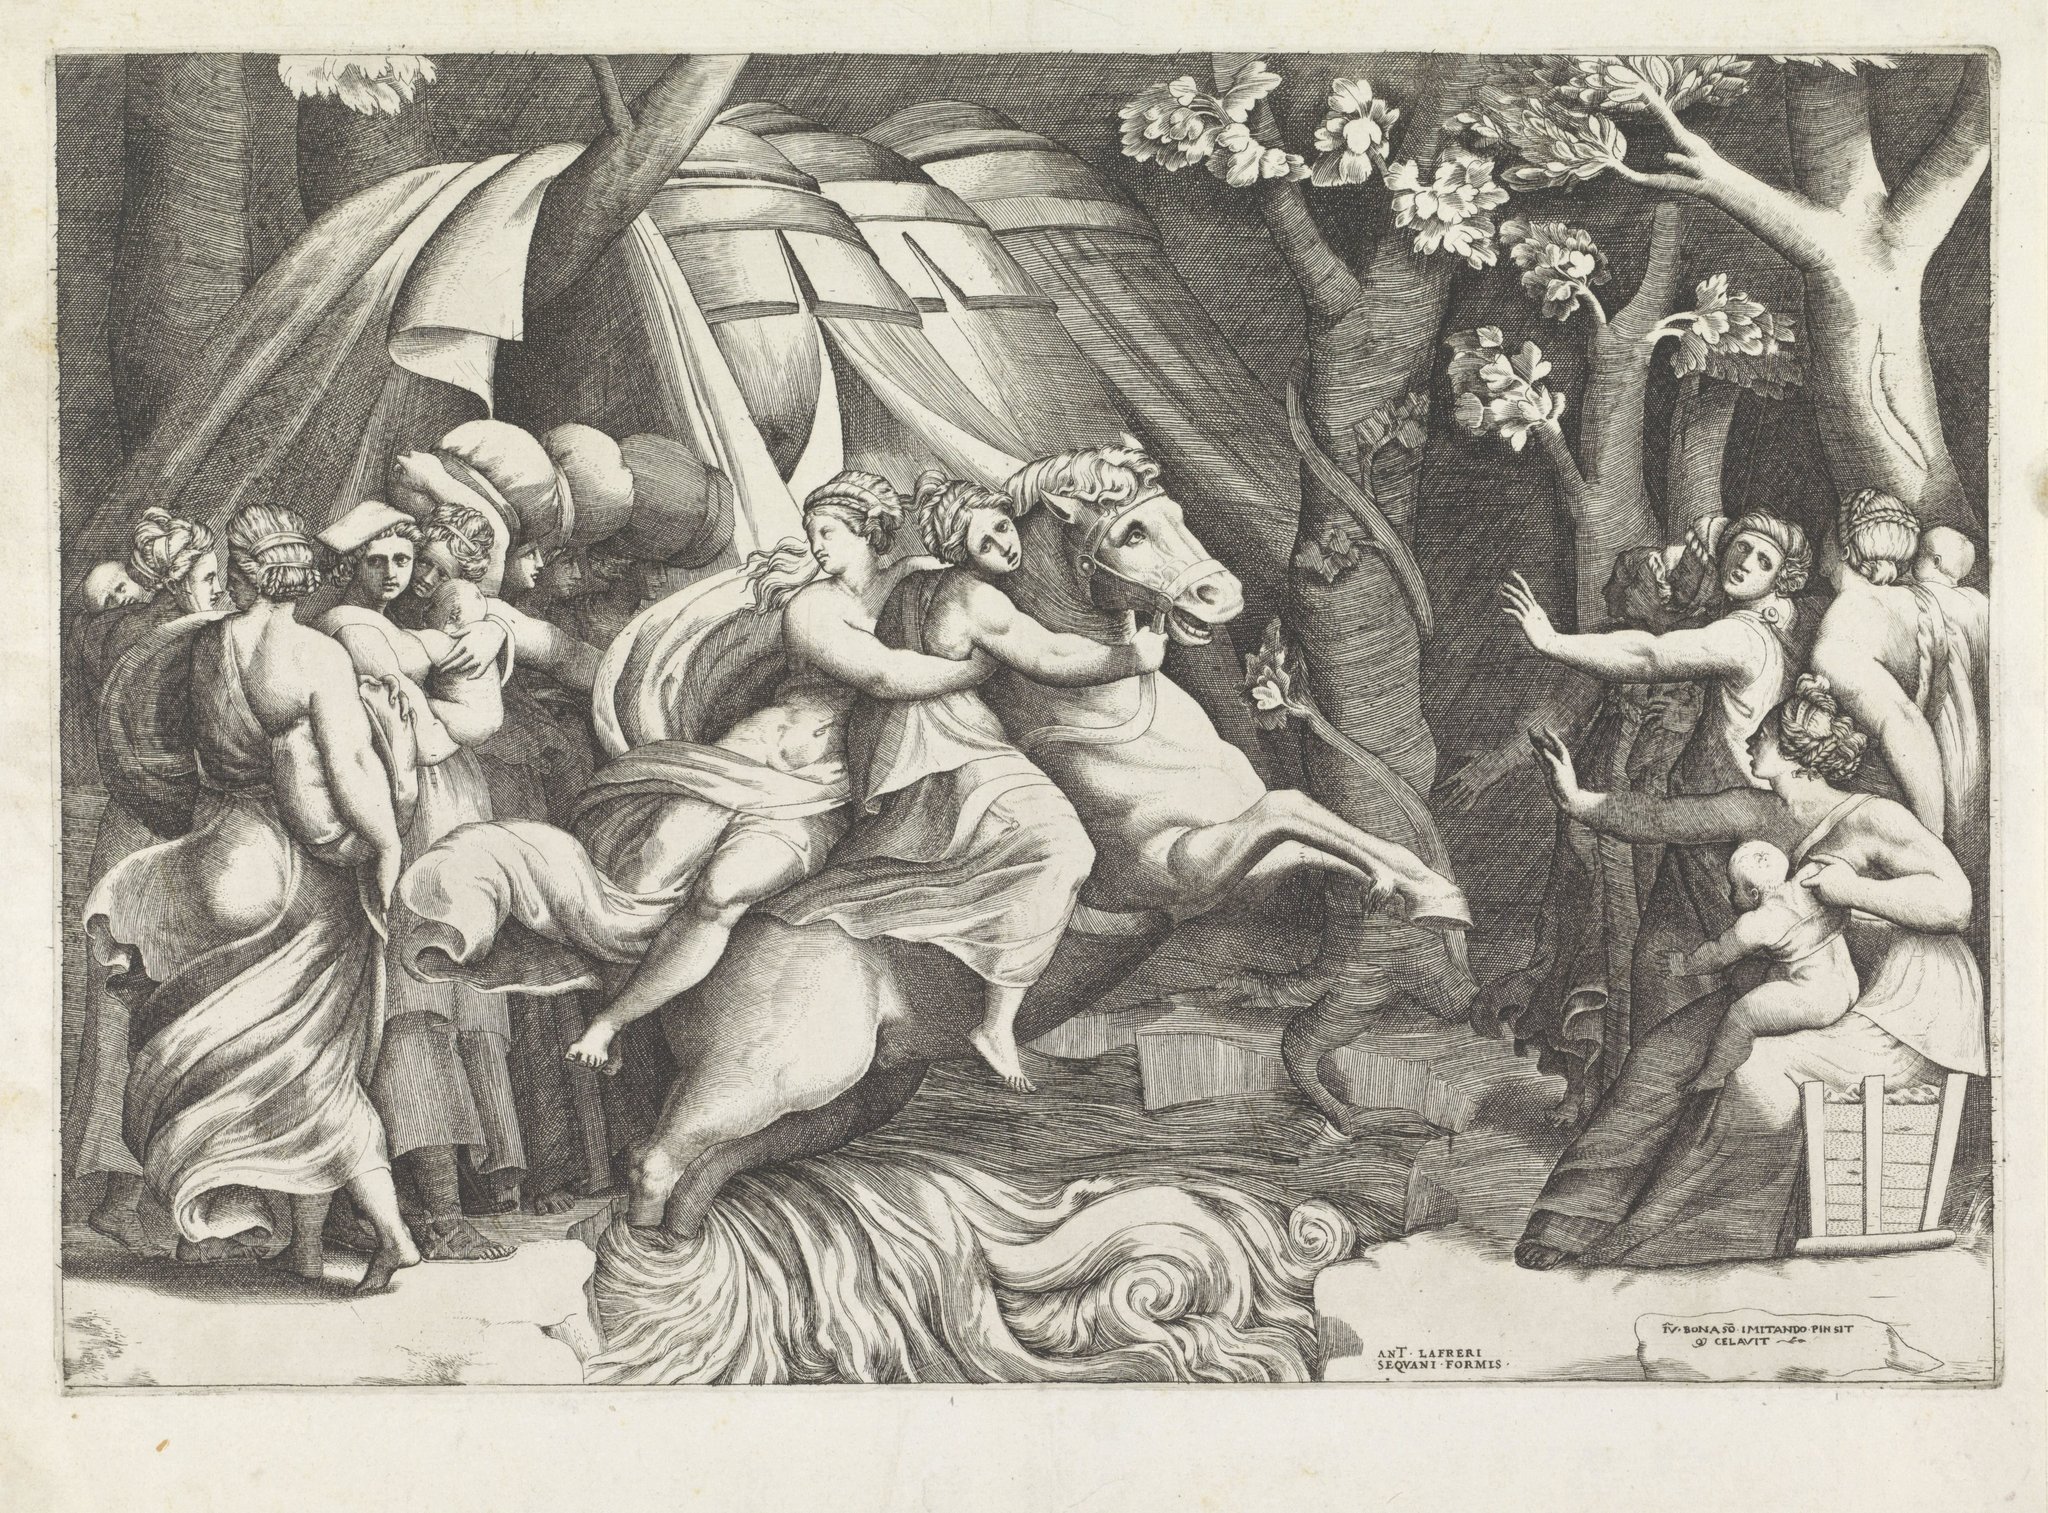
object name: print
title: Cloelia steekt de Tiber over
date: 1501-1580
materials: paper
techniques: engraving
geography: rome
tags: cloelia and her companions escape porsena's camp: she crosses the tiber on horseback and persuades her companions to swim after her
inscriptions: collector's mark: Lugt 240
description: De uit gevangenschap ontsnapte Cloelia vlucht naar Rome. Ze steekt te paard de rivier de Tiber over. Links op de oever staat een groep vrouwen met kinderen voor tenten. Rechts staan vrouwen op de oever die Cloelia proberen tegen te houden.